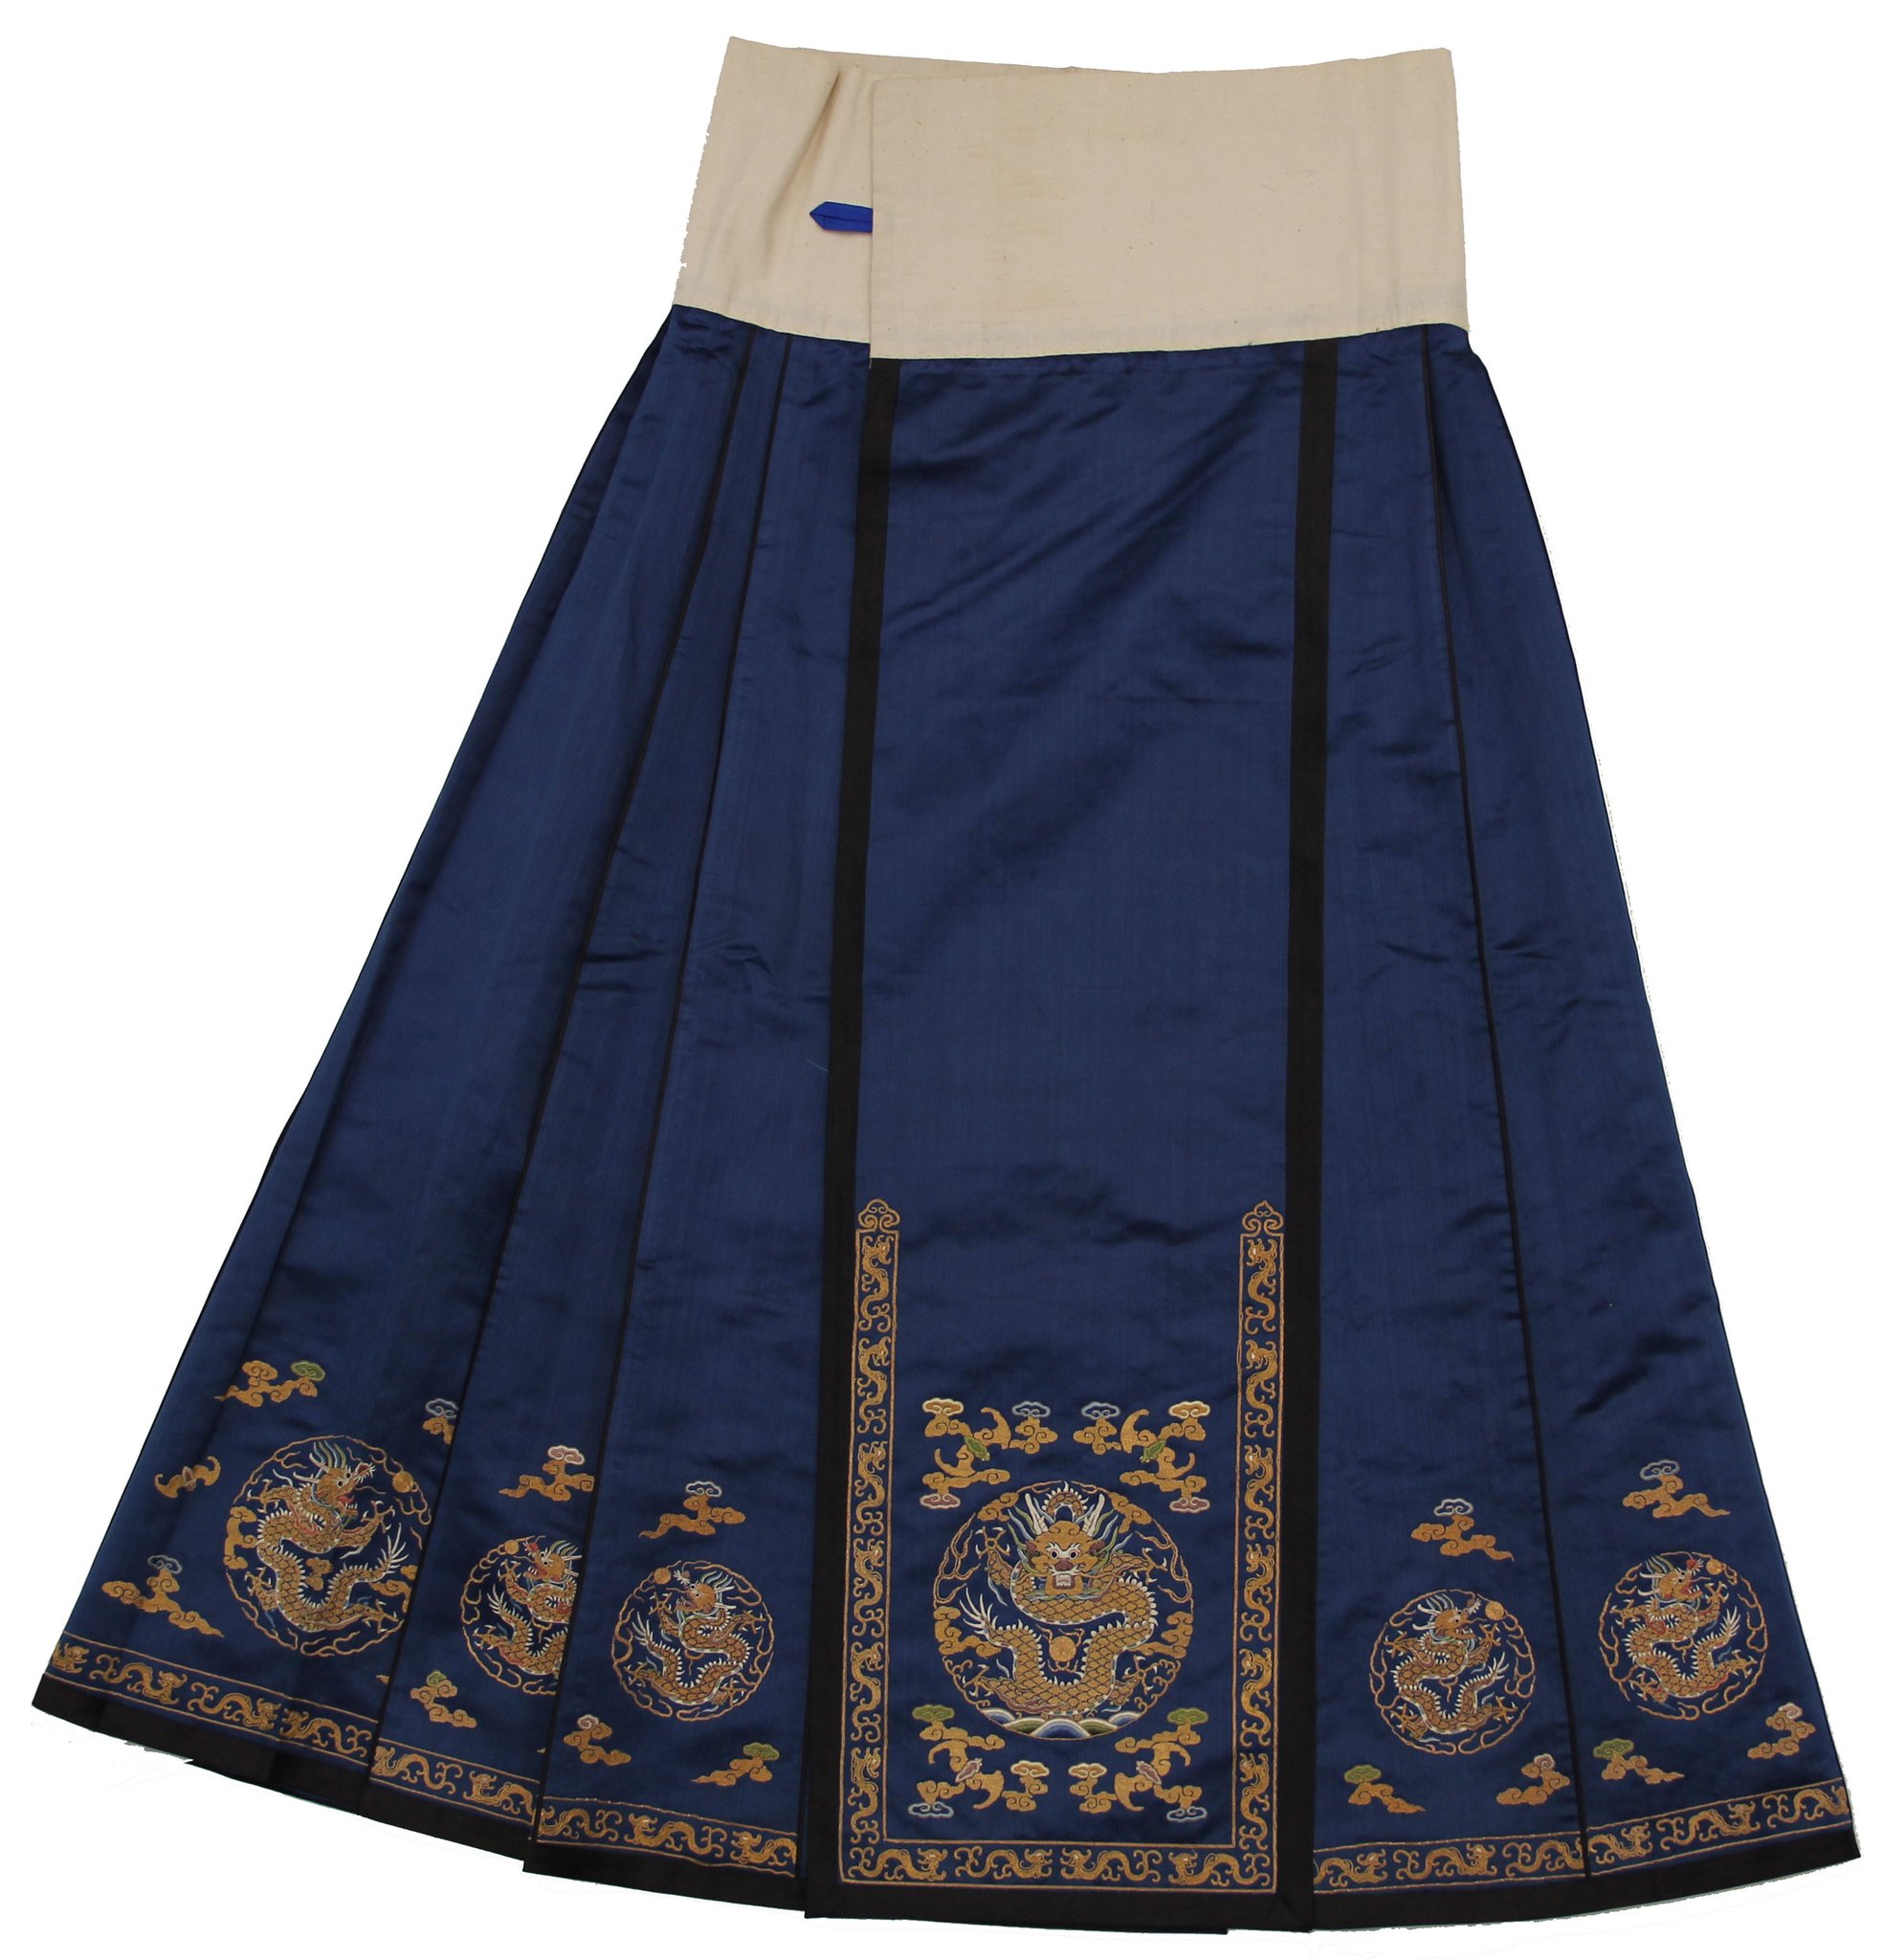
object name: skirt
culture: chinese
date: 1701-1900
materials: metal thread, silk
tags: dragons